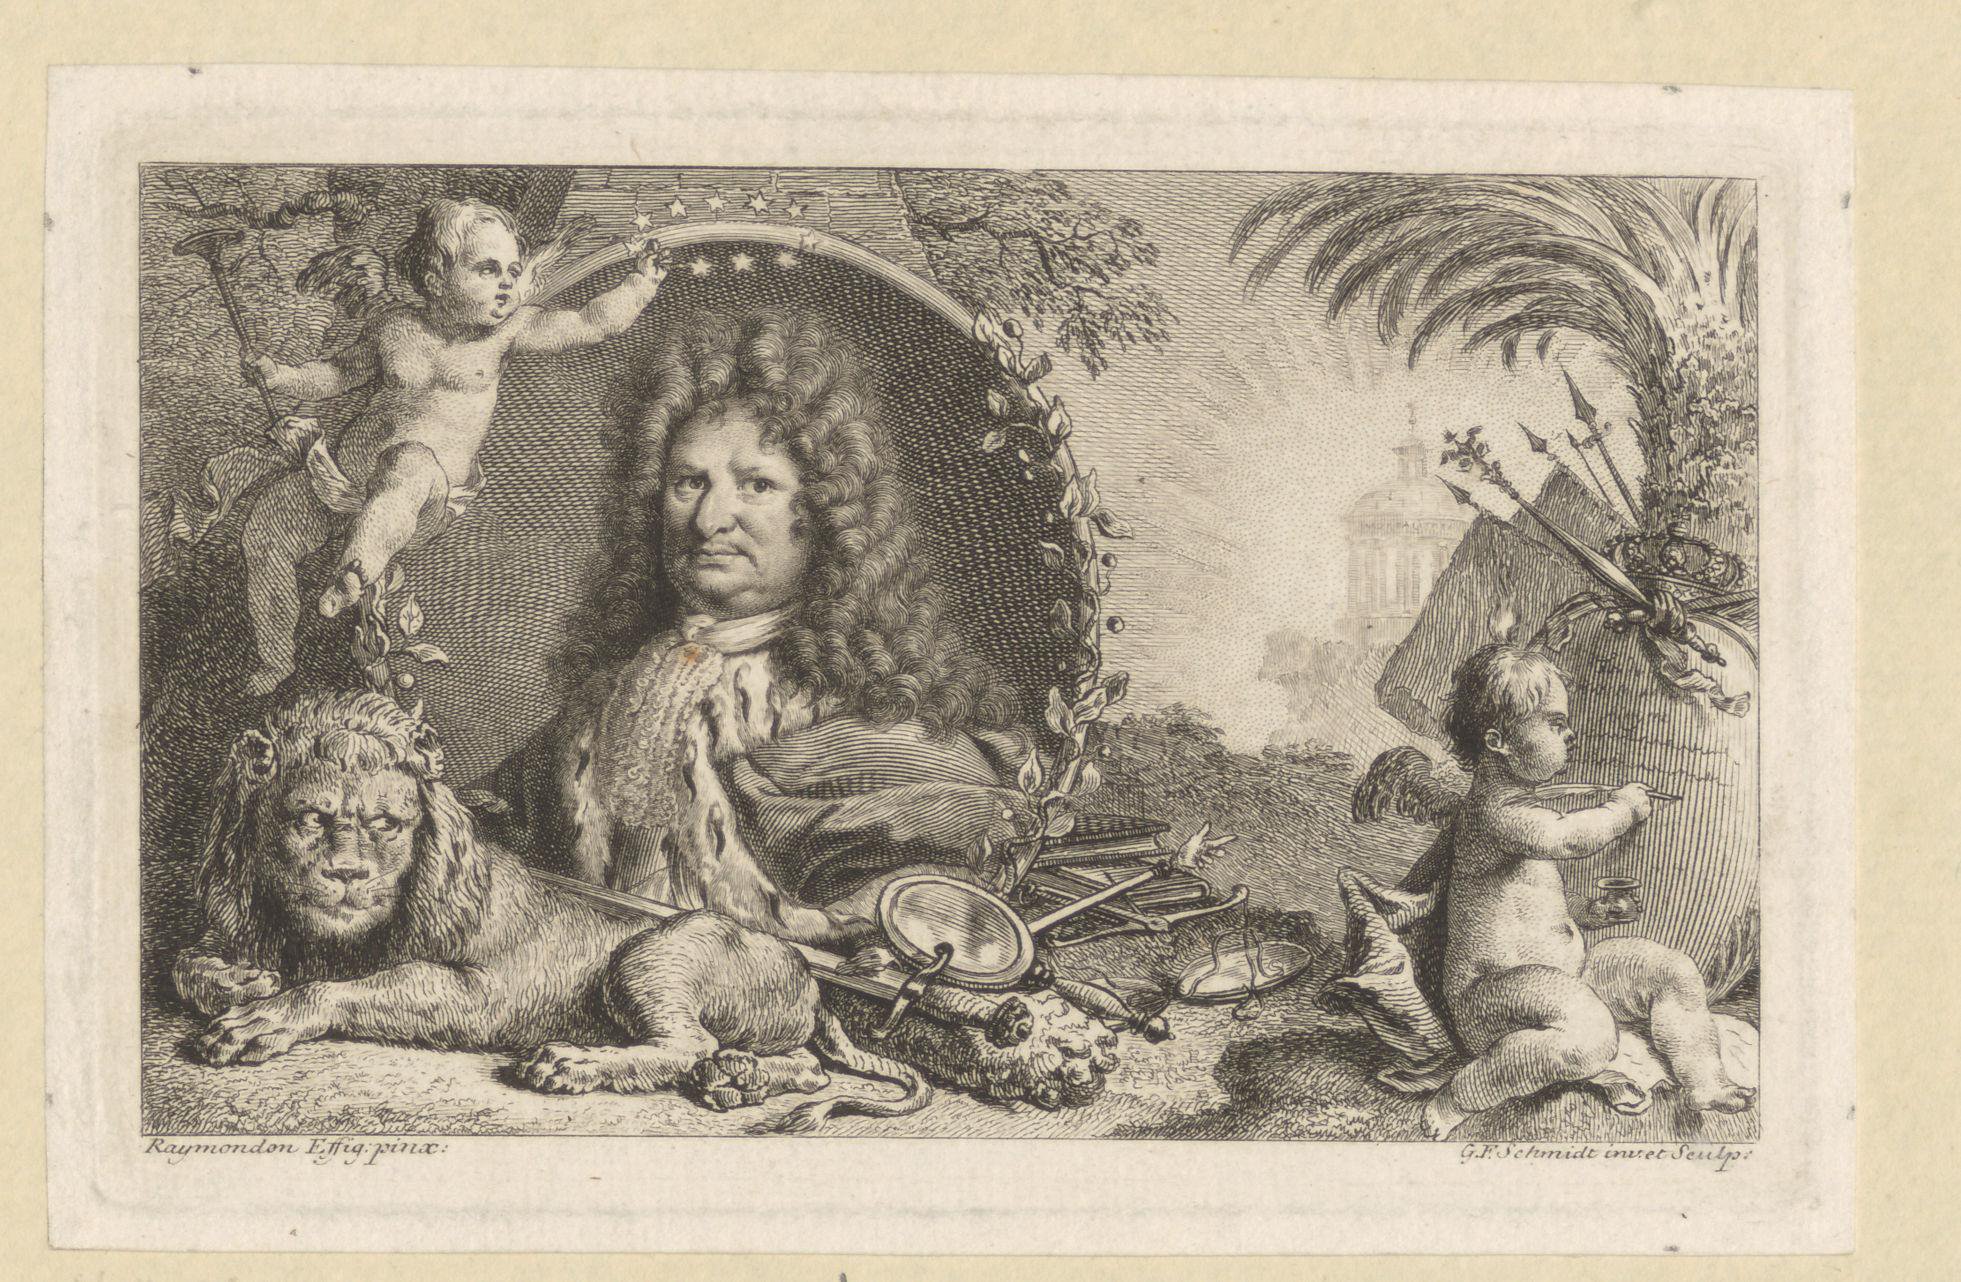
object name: print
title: Portret van Frederik Willem, keurvorst van Brandenburg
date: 1751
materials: paper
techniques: engraving, etching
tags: berlin, frederik willem van brandenburg (i), historical persons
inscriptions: collector's mark: Lugt 240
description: Prent ook gebruikt in: Frederik de Grote. Mémoires pour servir a l'histoire de la maison de Brandebourg. Sanssouci, Frederik de Grote, 1751.